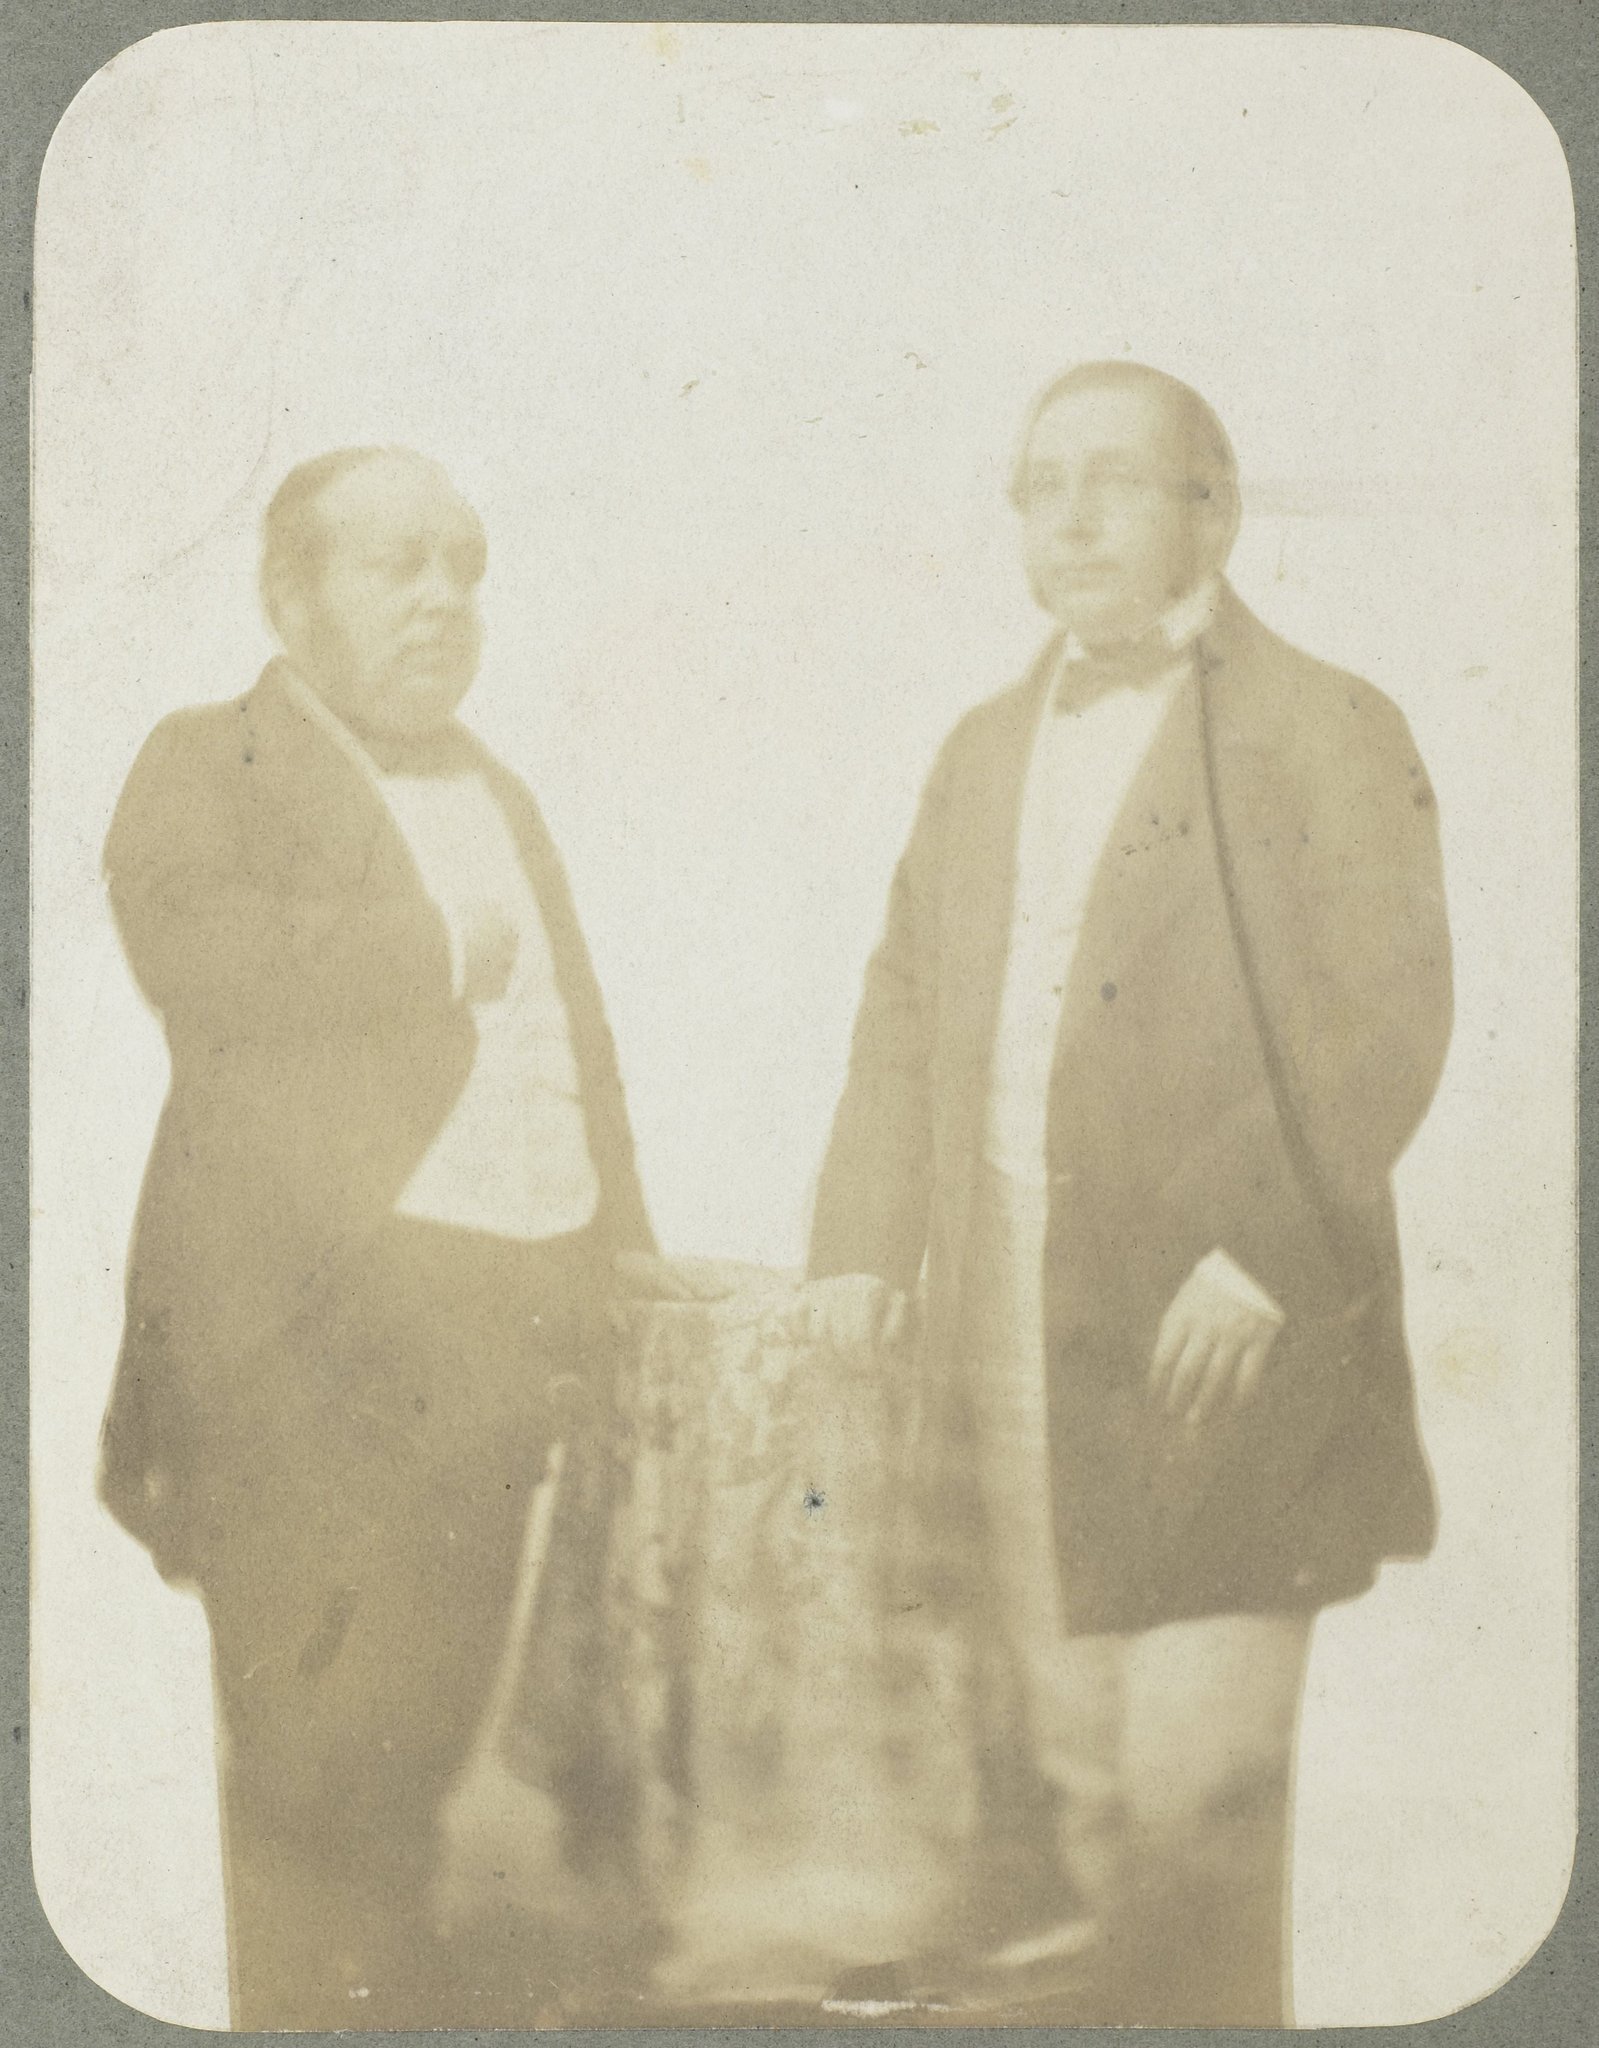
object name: photograph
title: Portret van de Oppenheims, zwagers van de fotograaf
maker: eduard isaac asser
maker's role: amateurfotograaf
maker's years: 1809-1894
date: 1852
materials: cardboard, paper, photographic support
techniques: salted paper print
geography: amsterdam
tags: historical persons